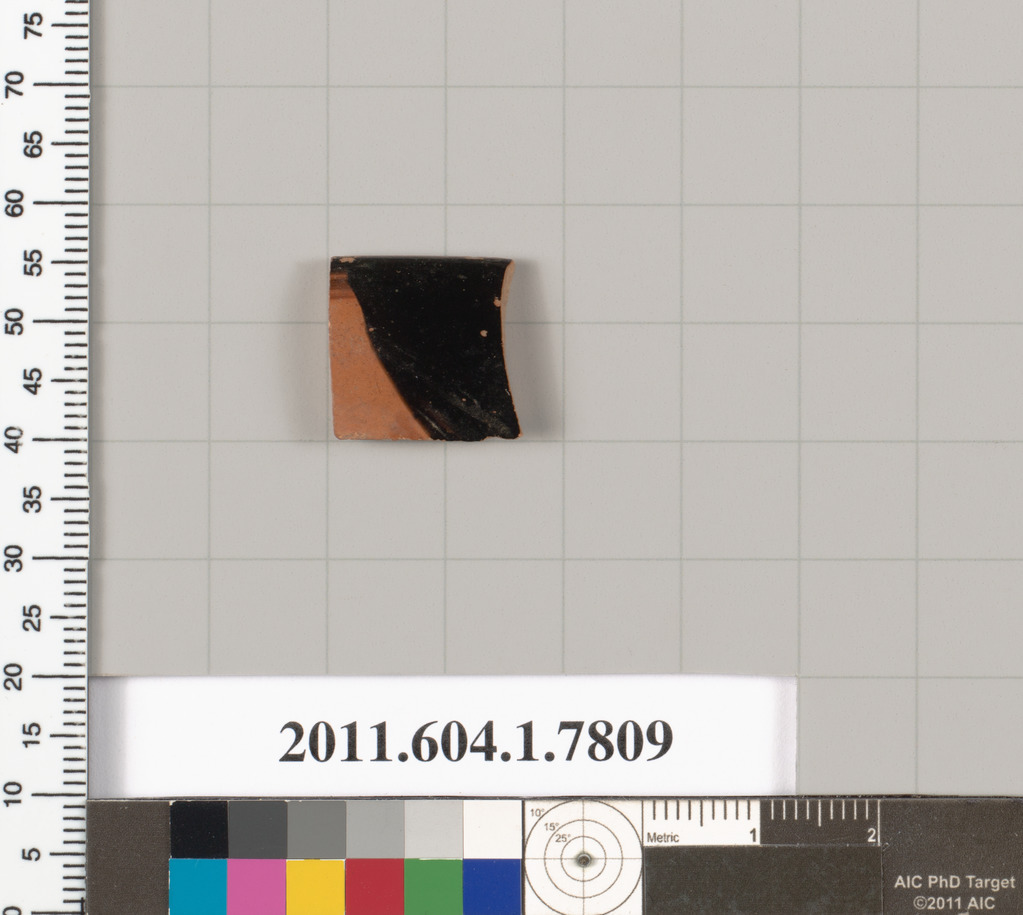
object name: kylix fragment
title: Terracotta rim fragment of a kylix (drinking cup)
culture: greek, attic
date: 460-450 BCE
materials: terracotta